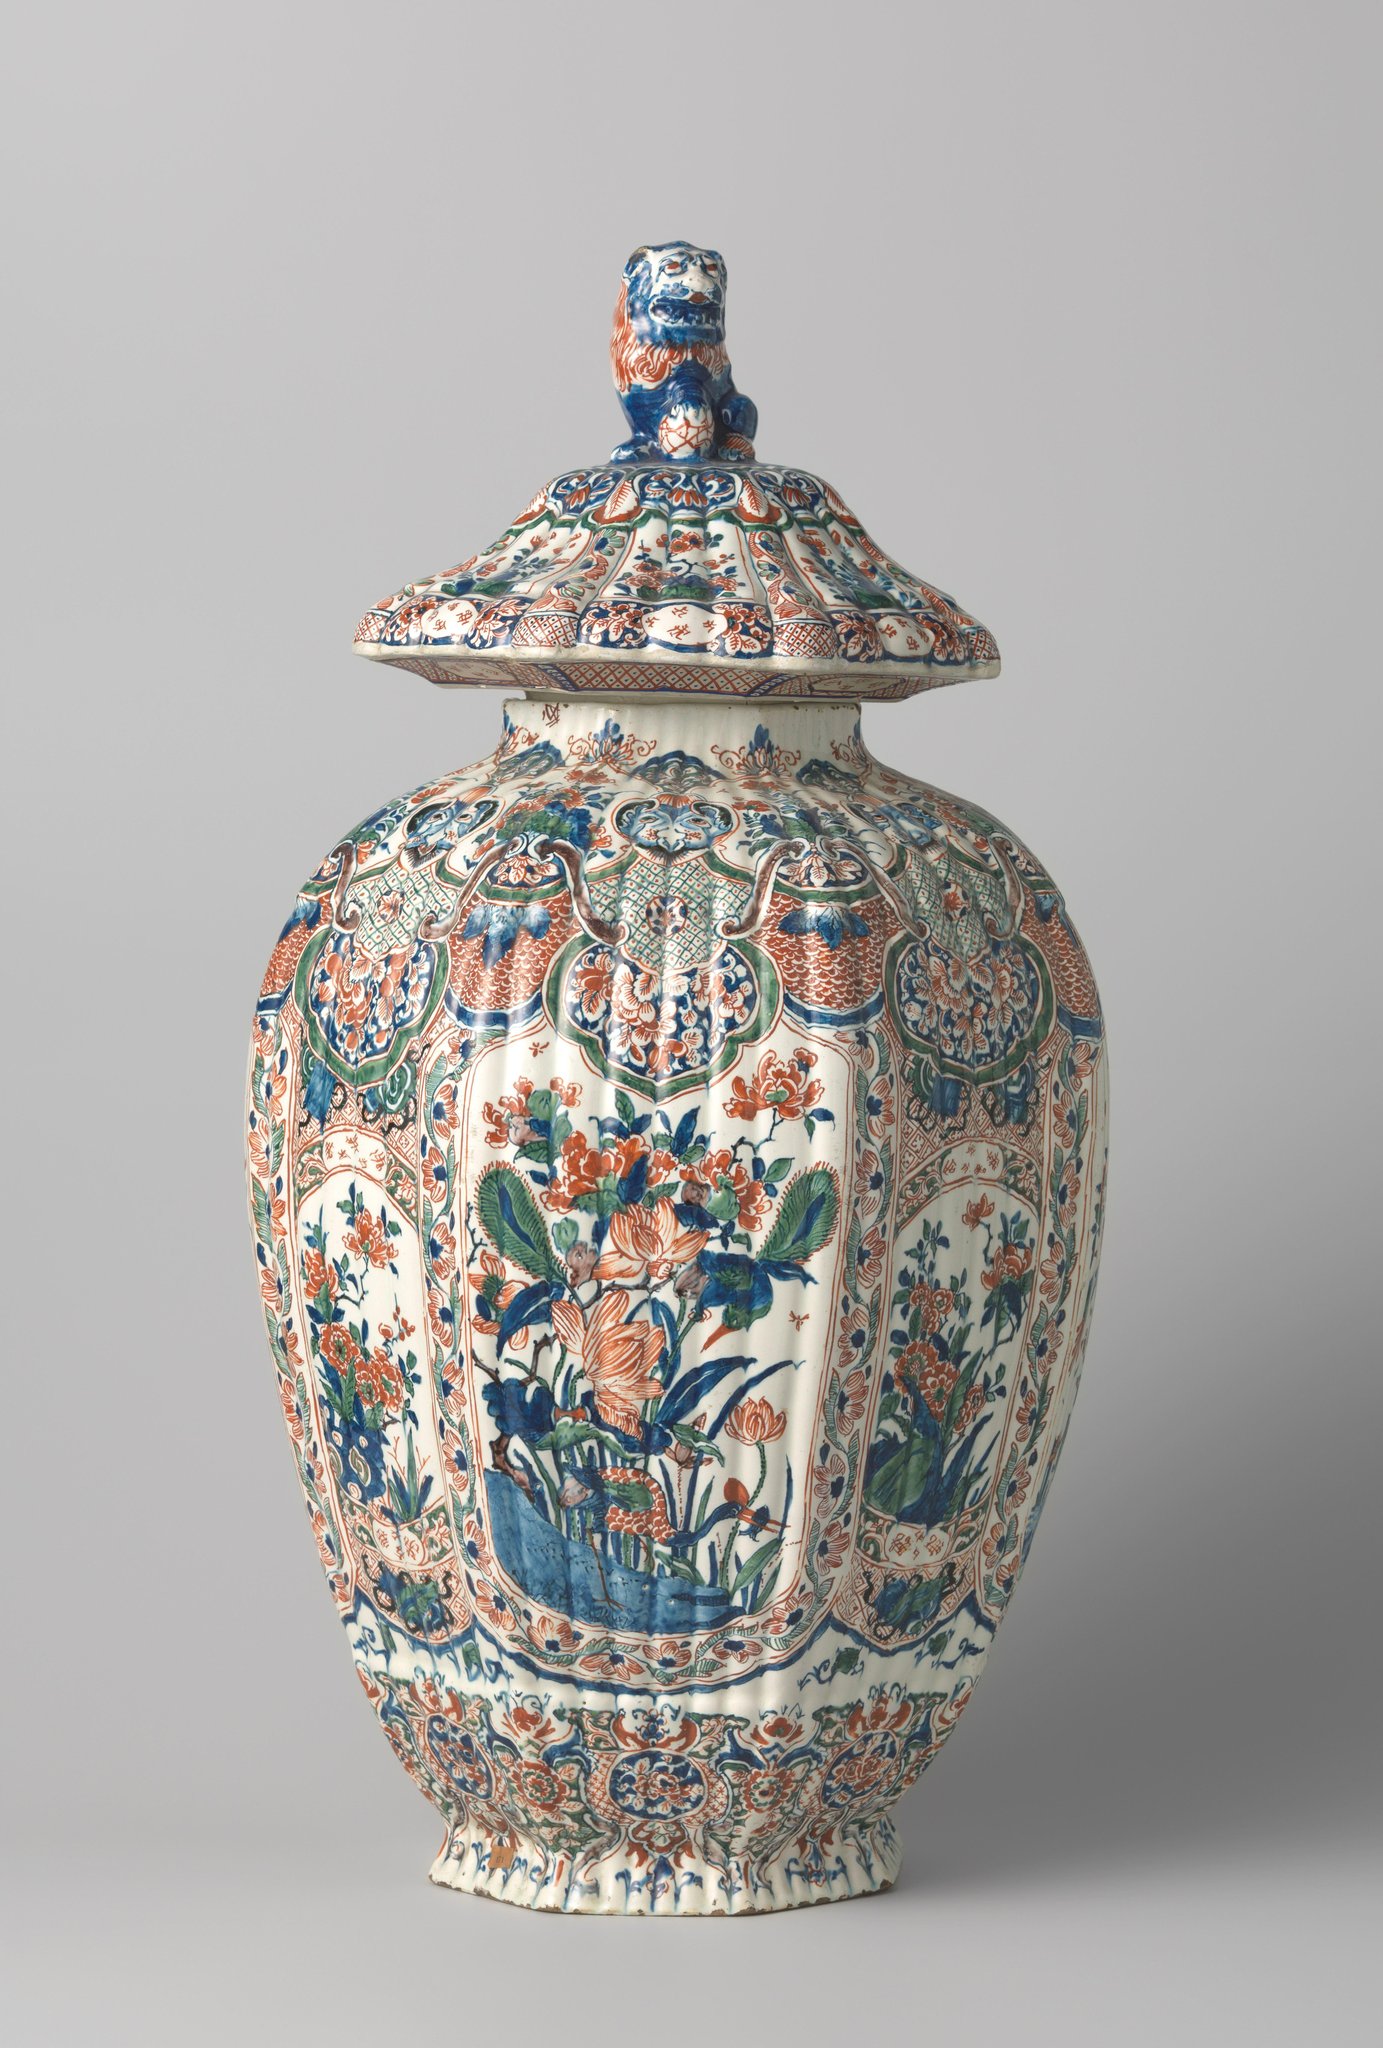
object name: vase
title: Vaas, veelkleurig beschilderd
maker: Anonymous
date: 1690-1720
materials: faience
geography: delft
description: Vaas van faïence. Veelkleurig beschilderd.